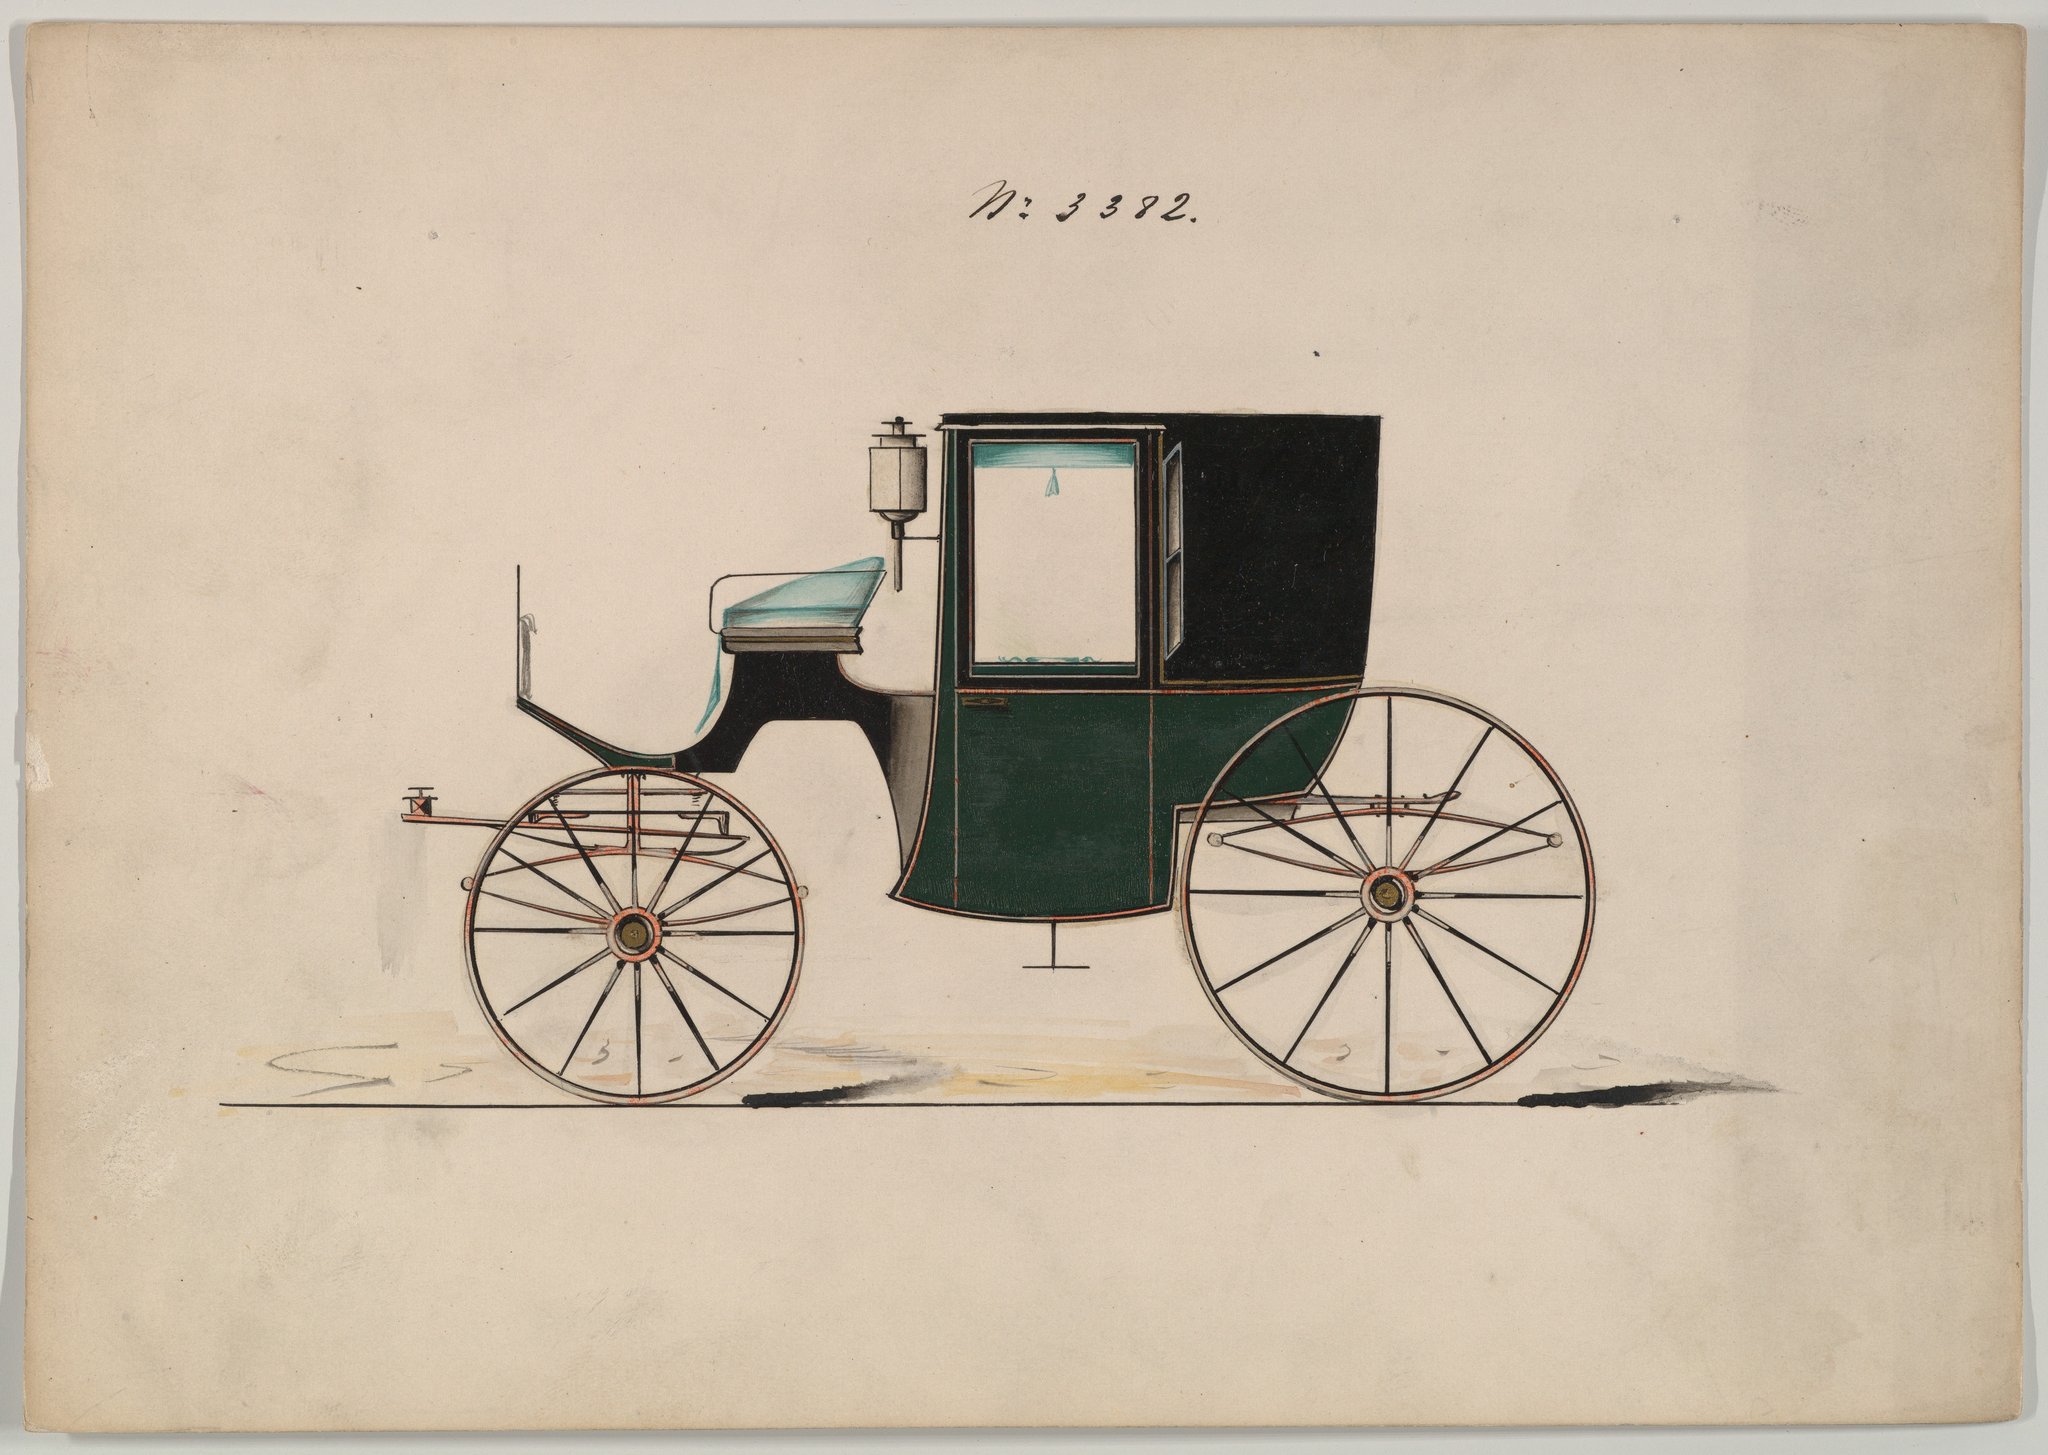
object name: drawing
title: Brougham #3382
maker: brewster & co.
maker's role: manufacturer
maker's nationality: american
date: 1877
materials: gouache, gum arabic, ink, watercolor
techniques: pen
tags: carriages